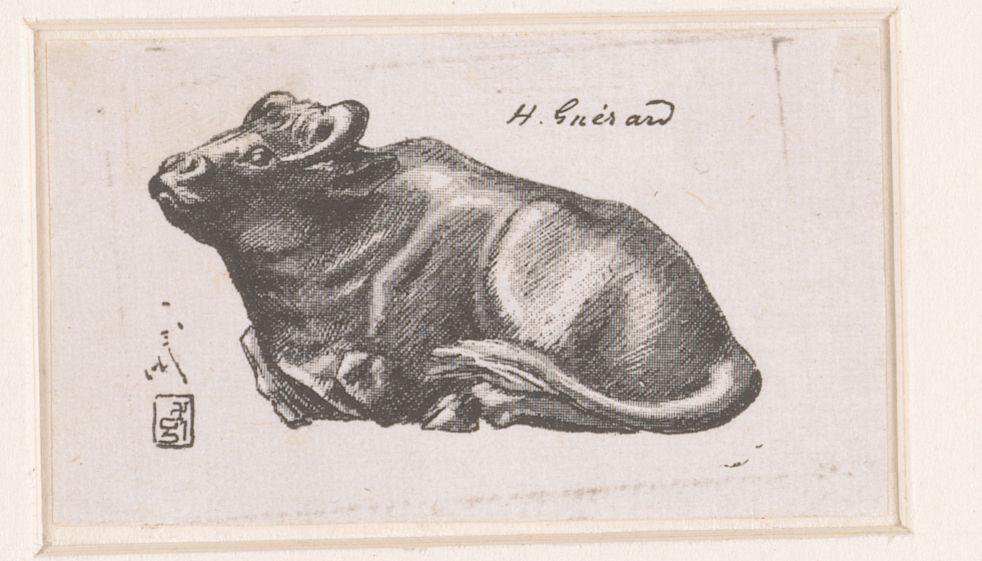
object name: print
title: Sculptuur van een liggende koe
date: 1883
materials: paper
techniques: engraving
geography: paris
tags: cow, sculpture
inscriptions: collector's mark: Lugt 2228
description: Prent uit: Gonse, Louis. L'Art Japonais. Parijs: Albert Quantin, 1883, dl. 2, p. 92.